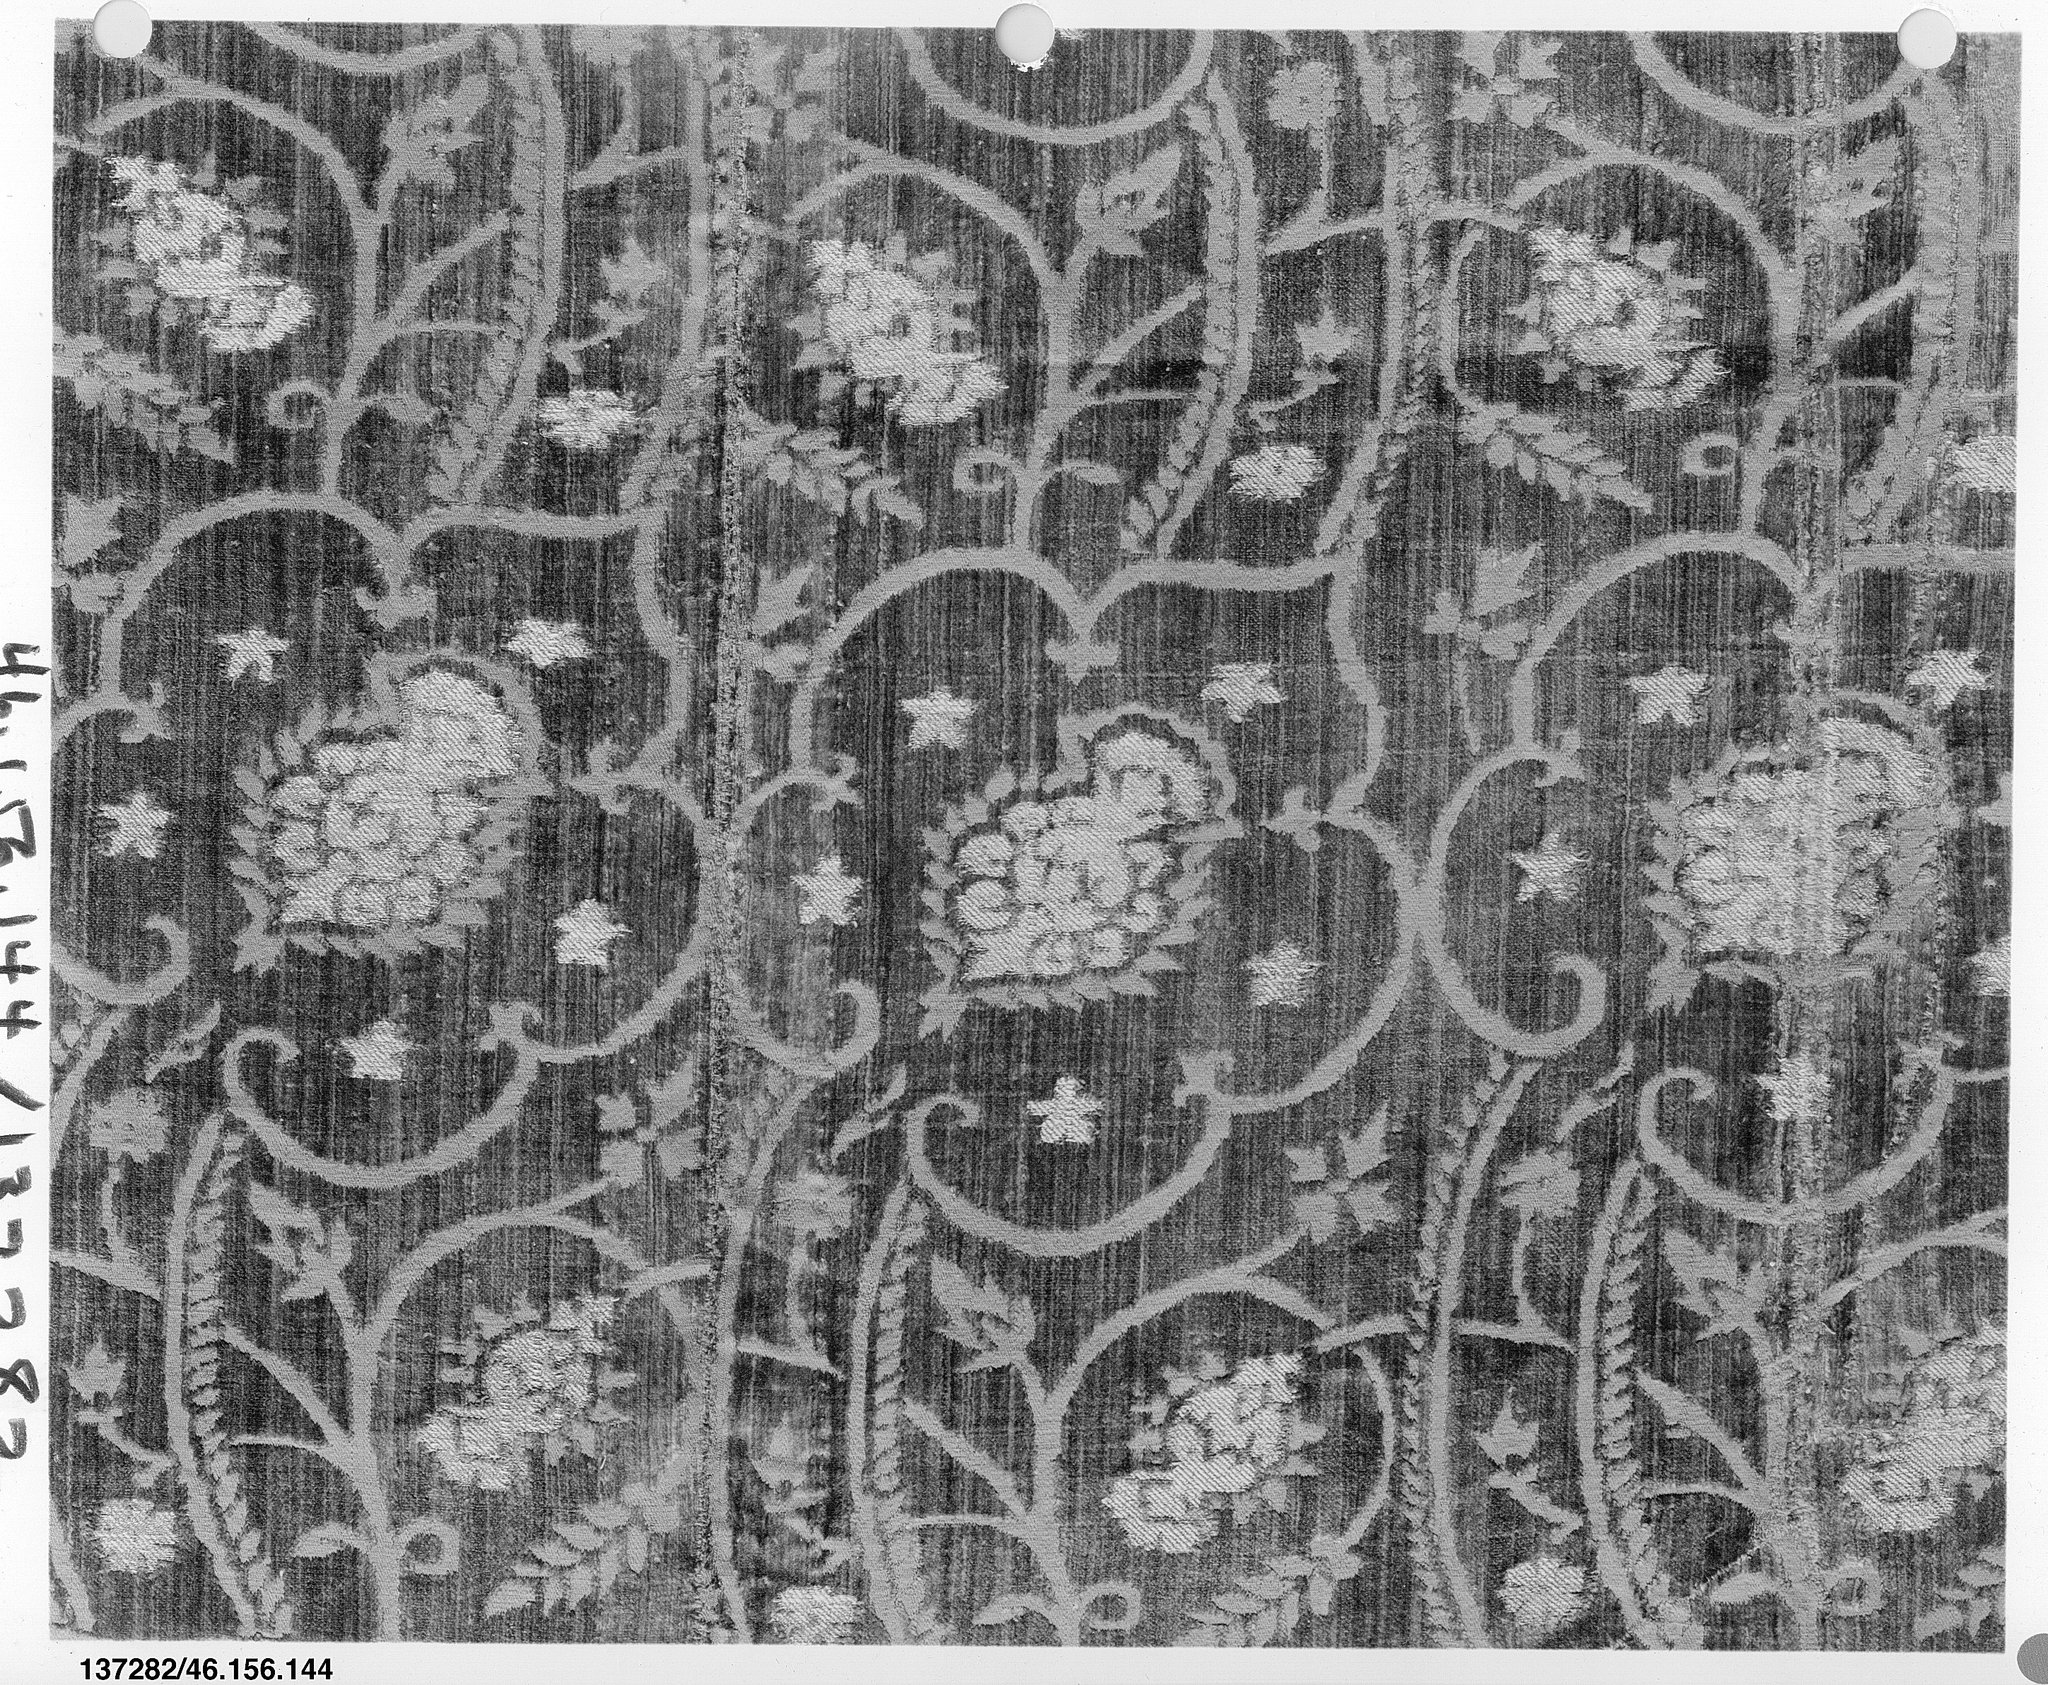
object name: piece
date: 1451-1500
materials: metal thread, silk